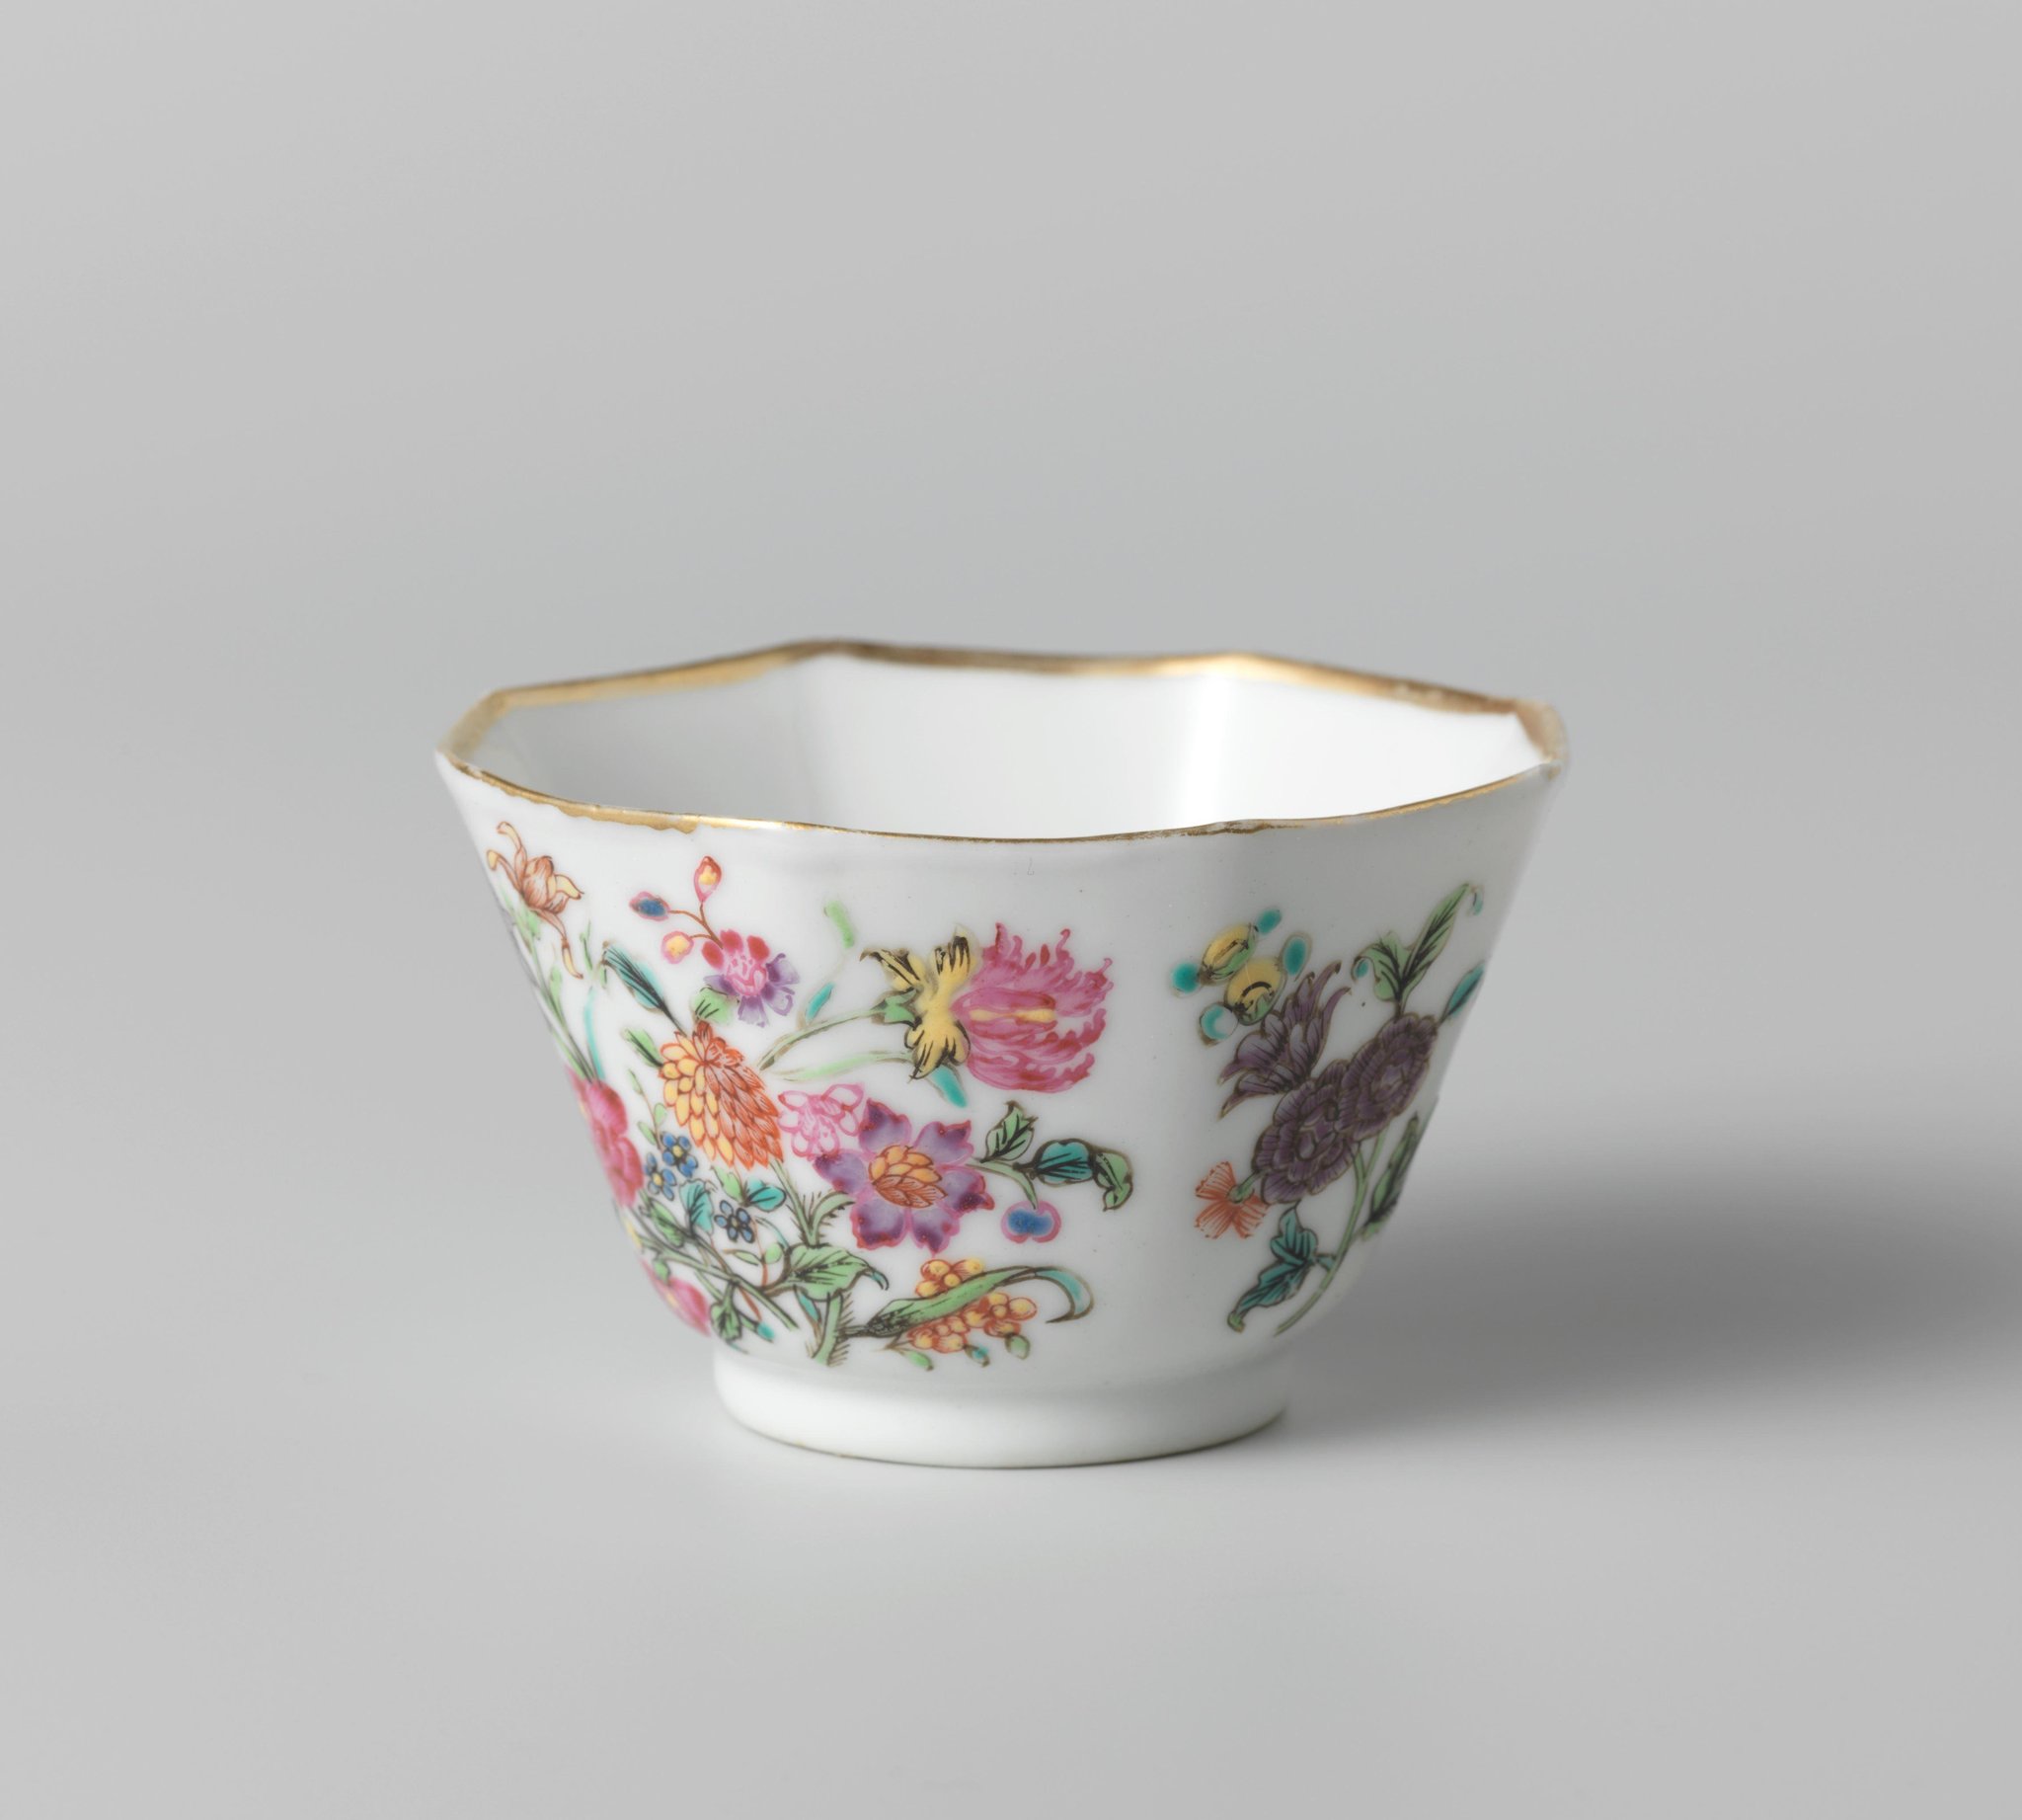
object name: kop en schotel, kop en schotel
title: Octagonal cup with flower sprays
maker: Anonymous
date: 1750-1774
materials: glaze, gold, paint, porcelain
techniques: firing, forming, gilding, turning, vitrification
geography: china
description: Achthoekige kop van porselein, beschilderd op het glazuur in blauw, rood, roze, groen, geel, aubergine en zwart. Op de bodem een bloemgroep en op de wand vier bloemtakken. Famille rose.